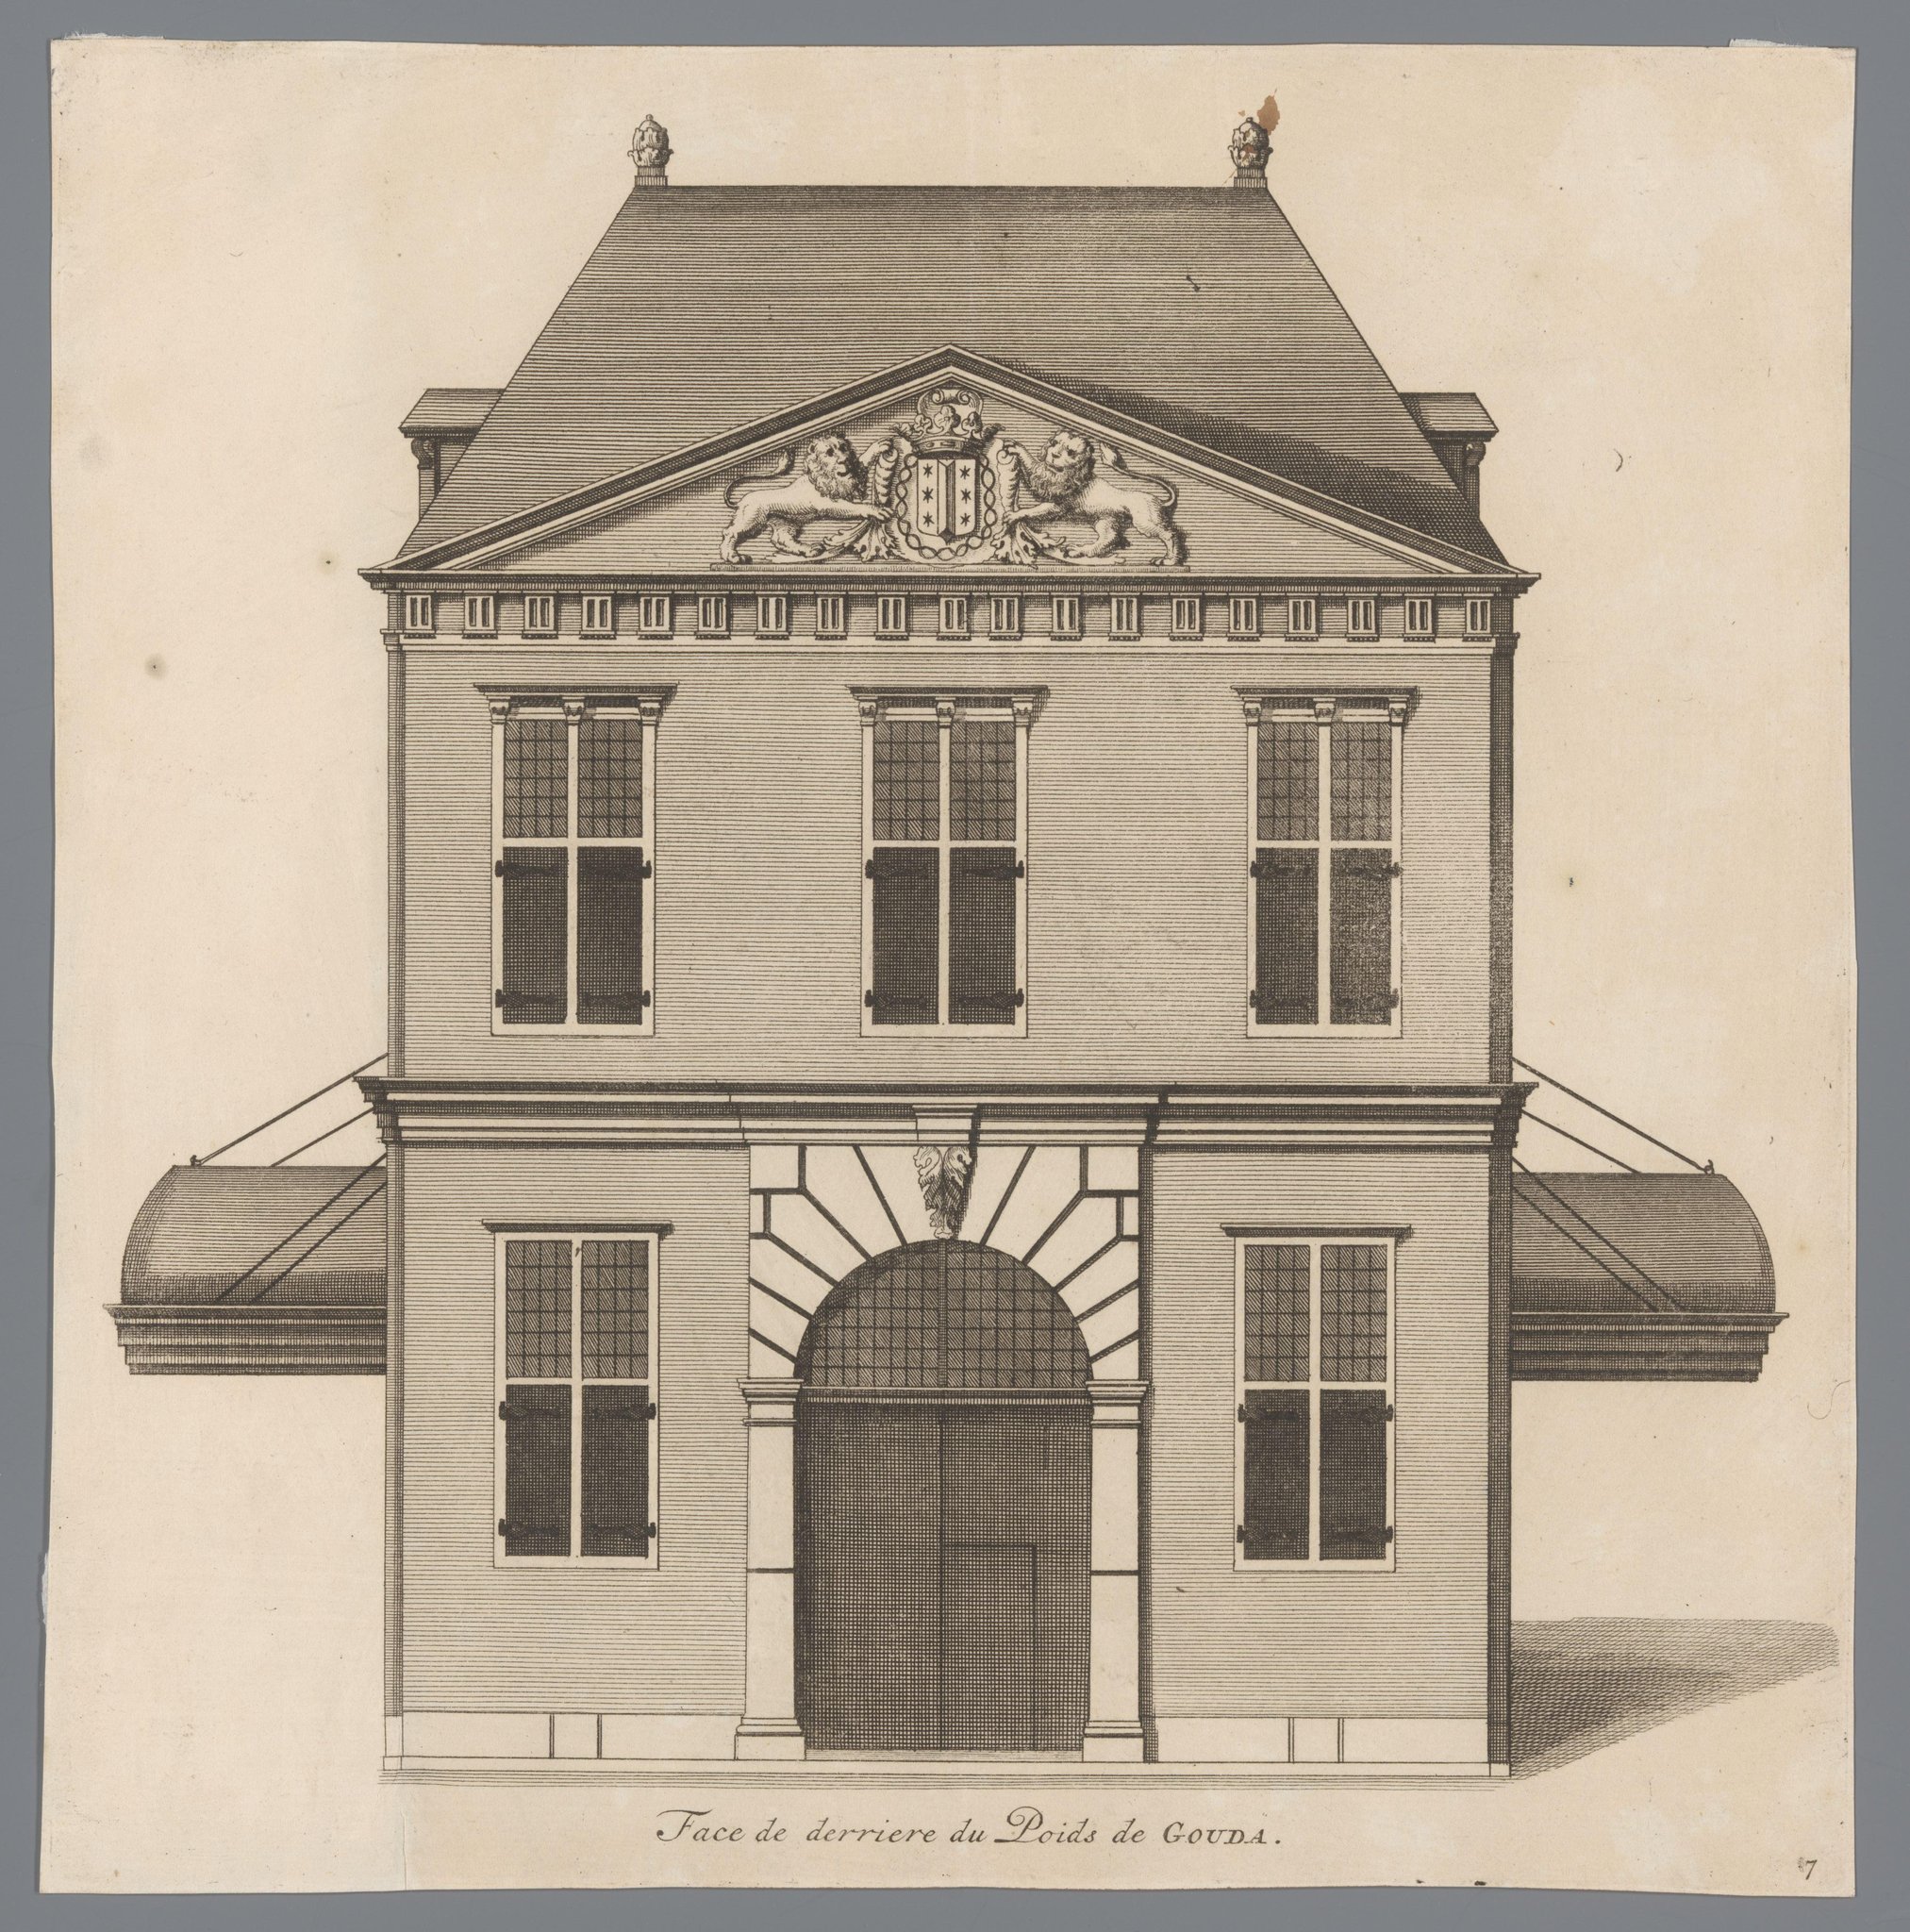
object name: book illustration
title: Gezicht op de achterzijde van de Waag te Gouda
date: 1715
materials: paper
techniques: etching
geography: leiden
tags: exterior ~ representation of a building, weigh-house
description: Prent uit: Les Ouvrages d'Architecture ordonnez par Pierre Post (...). Leiden: Pieter van der Aa, 1705.